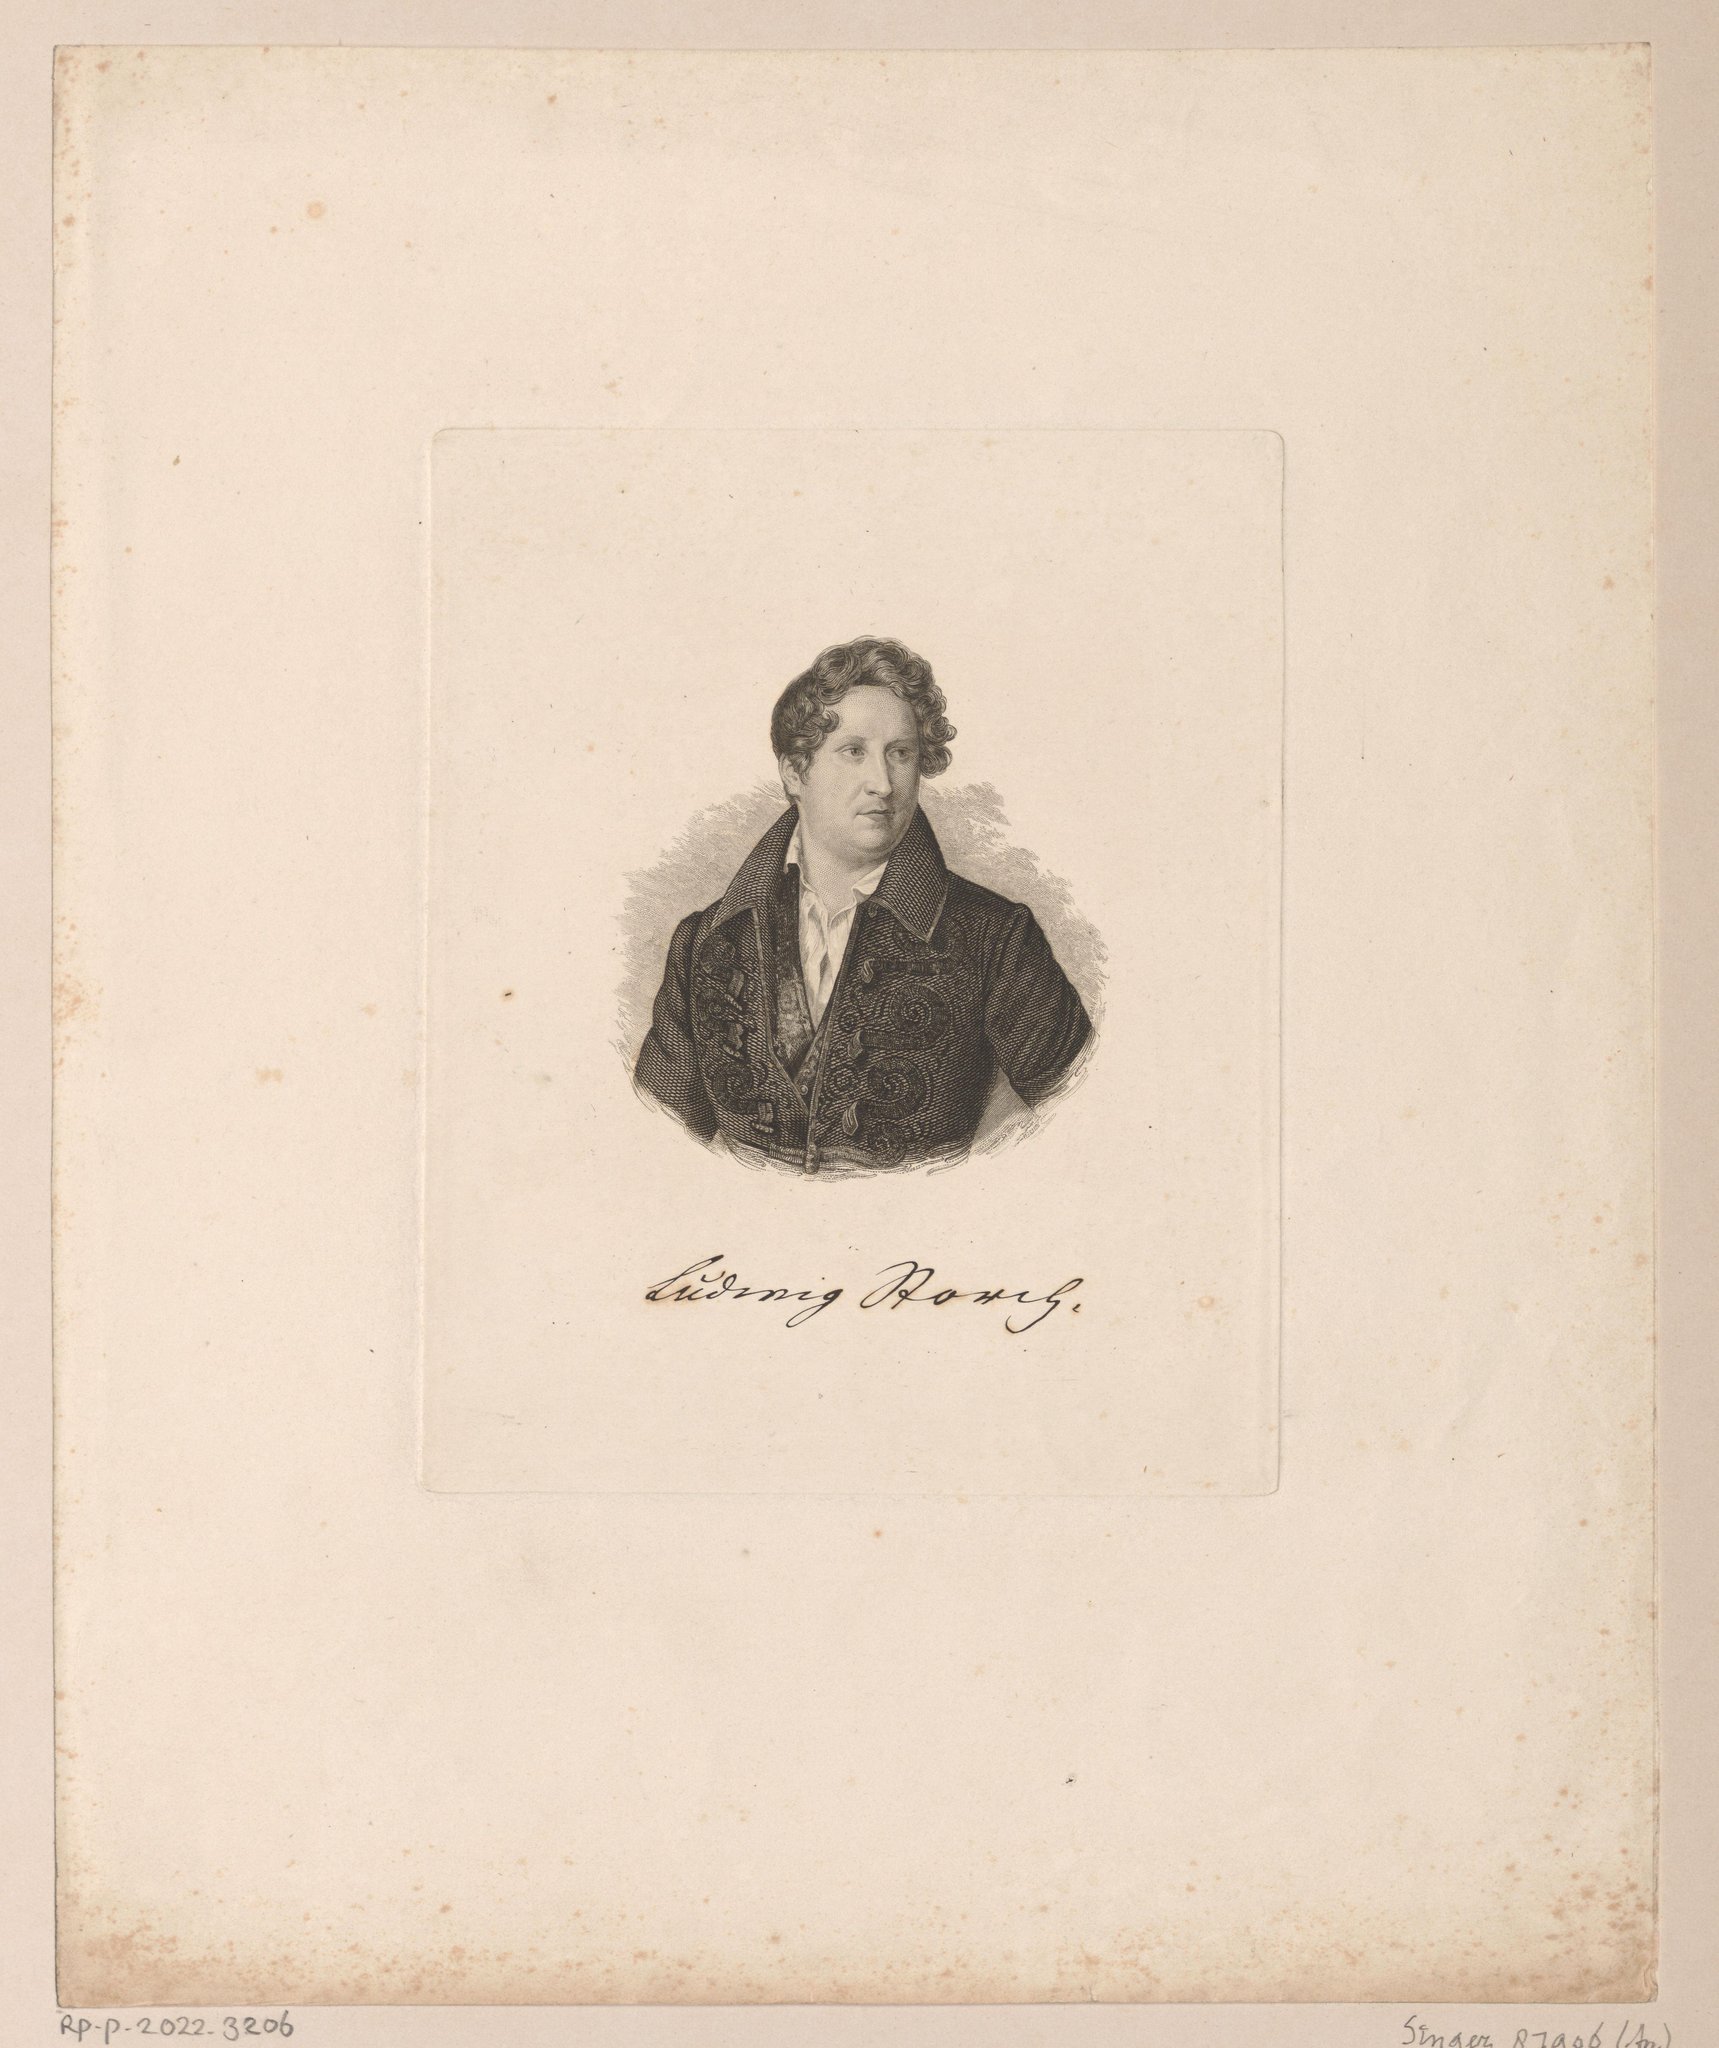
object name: print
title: Portret van Ludwig Storch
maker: Anonymous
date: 1823-1899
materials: paper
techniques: engraving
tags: historical persons, portrait of a writer